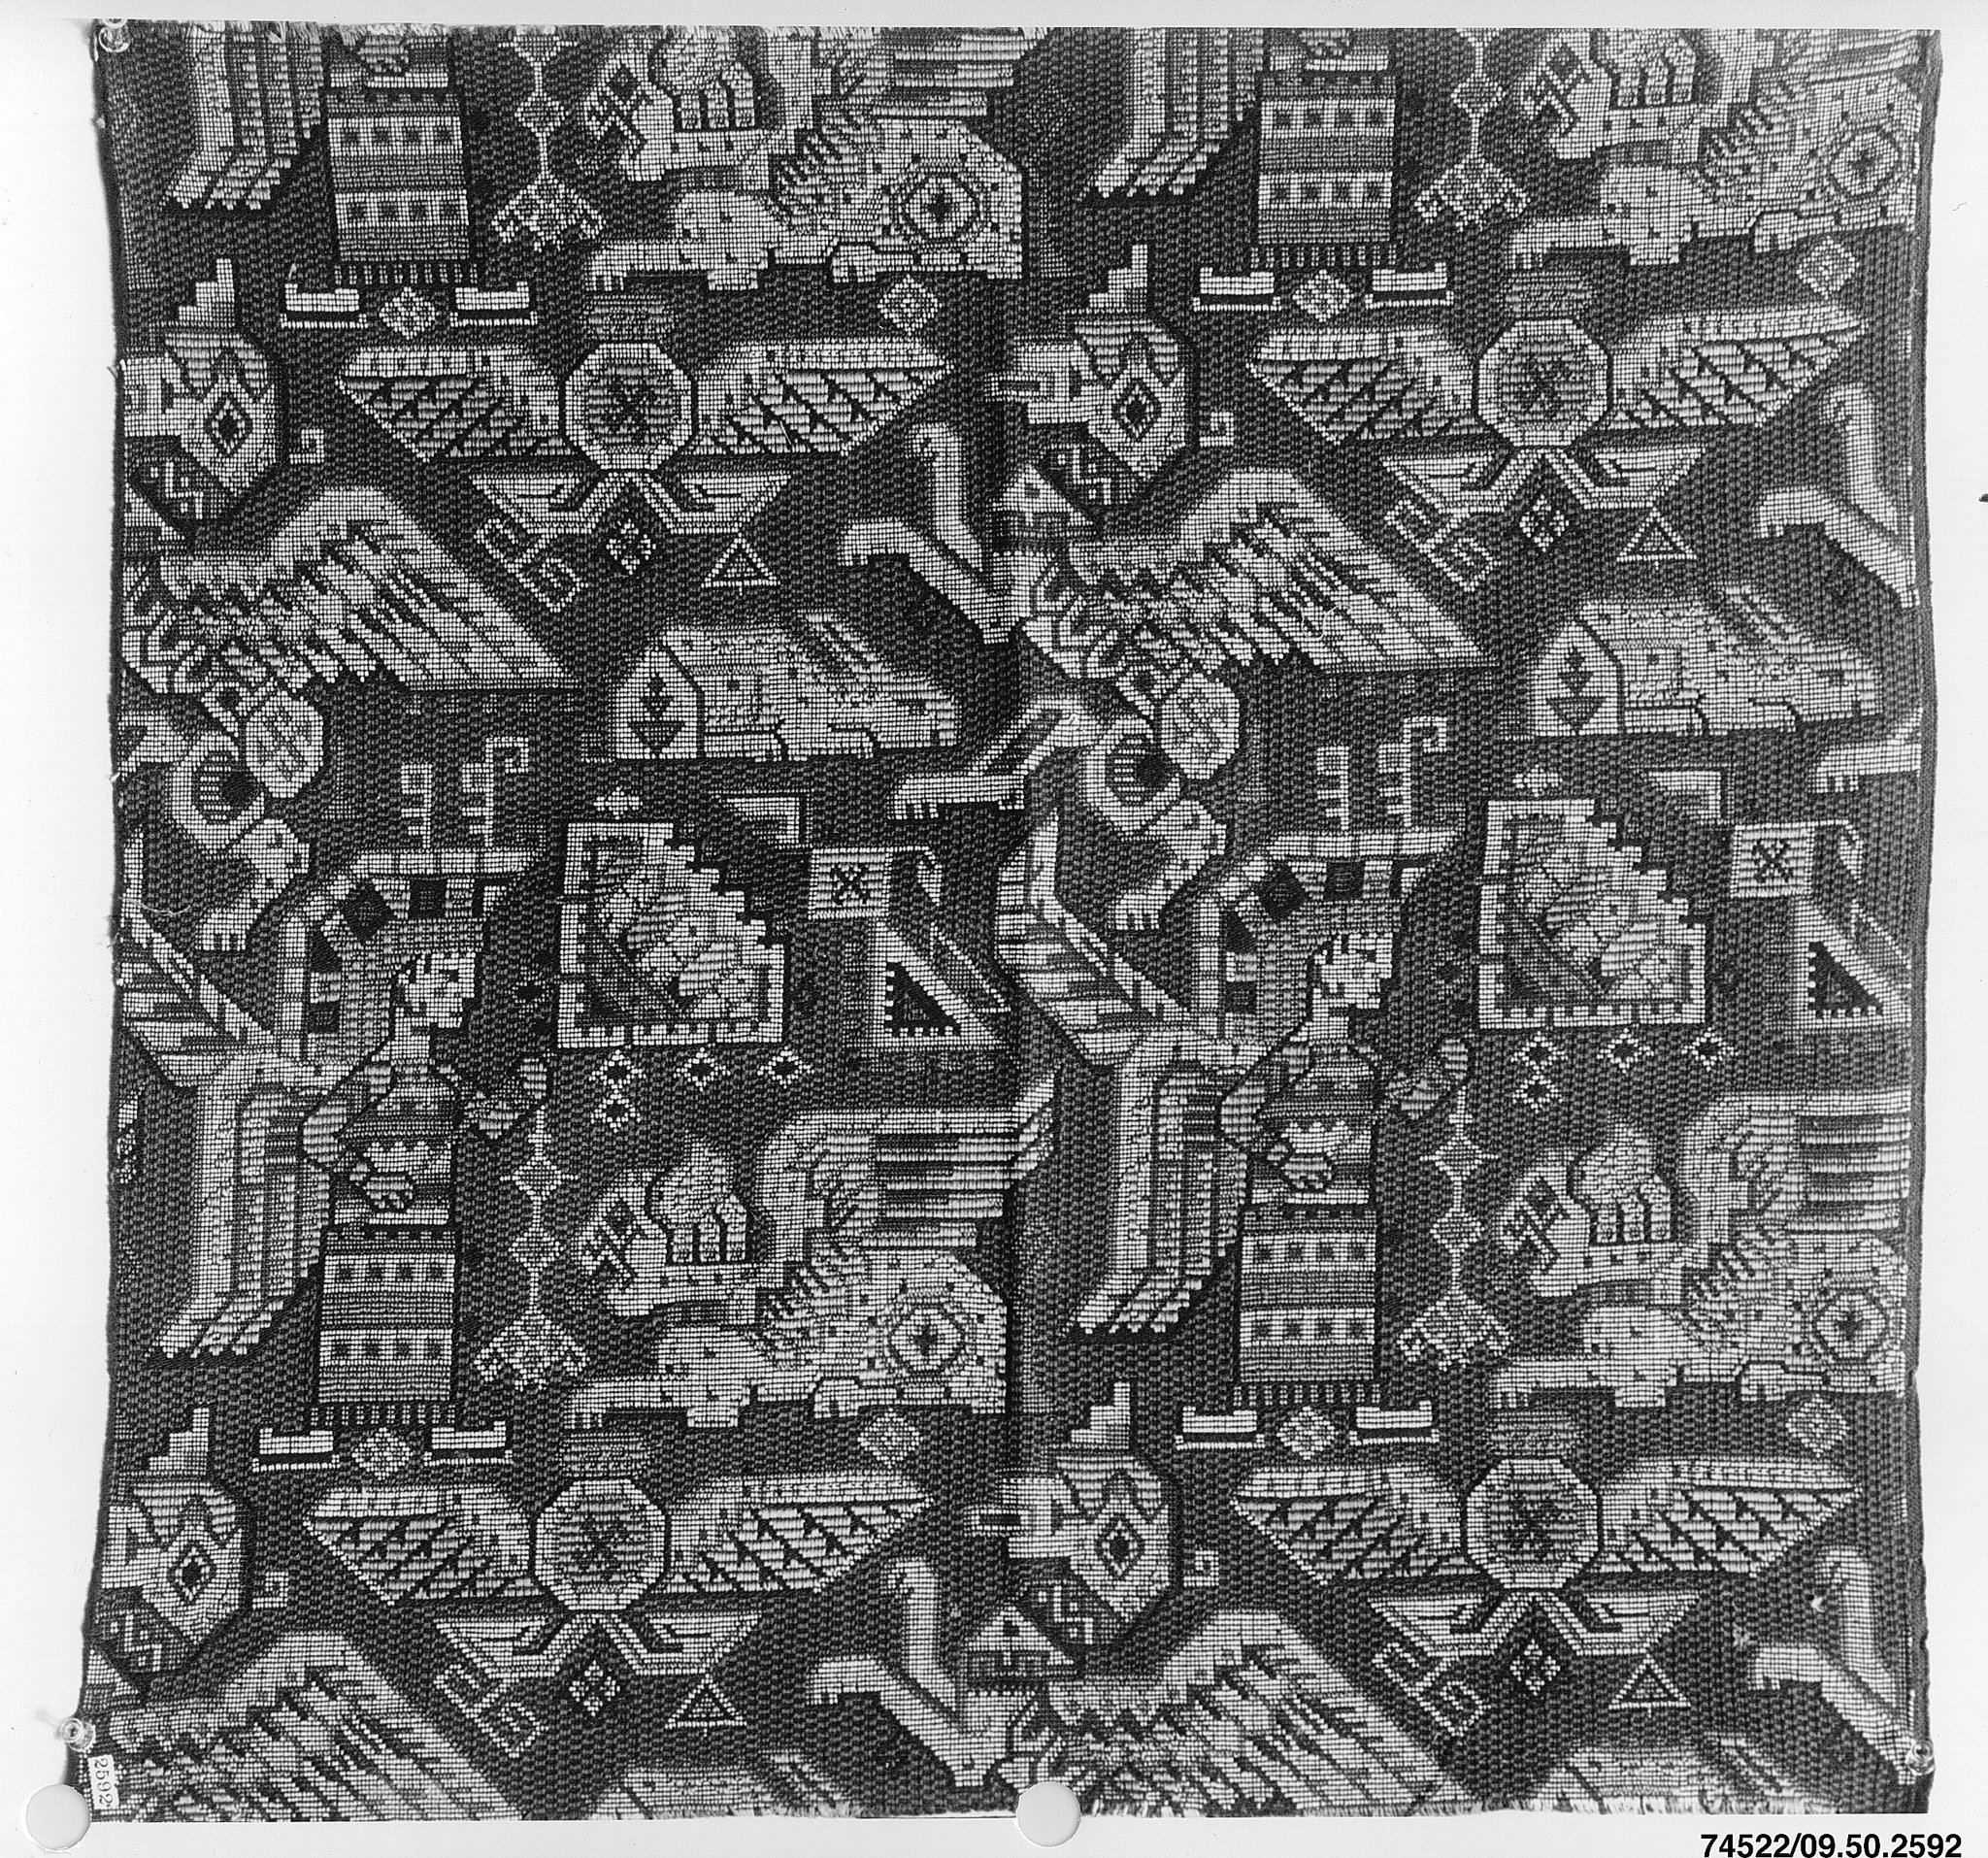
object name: piece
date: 1801-1900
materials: cotton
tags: human figures,animals